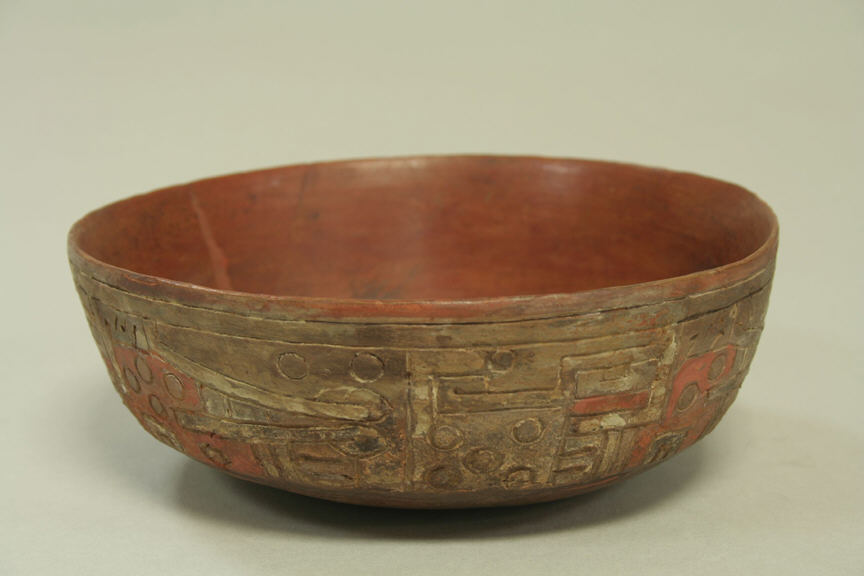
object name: bowl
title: Incised Painted Bowl with Fox Motif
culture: paracas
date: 700-401 BCE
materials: ceramic, pigment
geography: peru